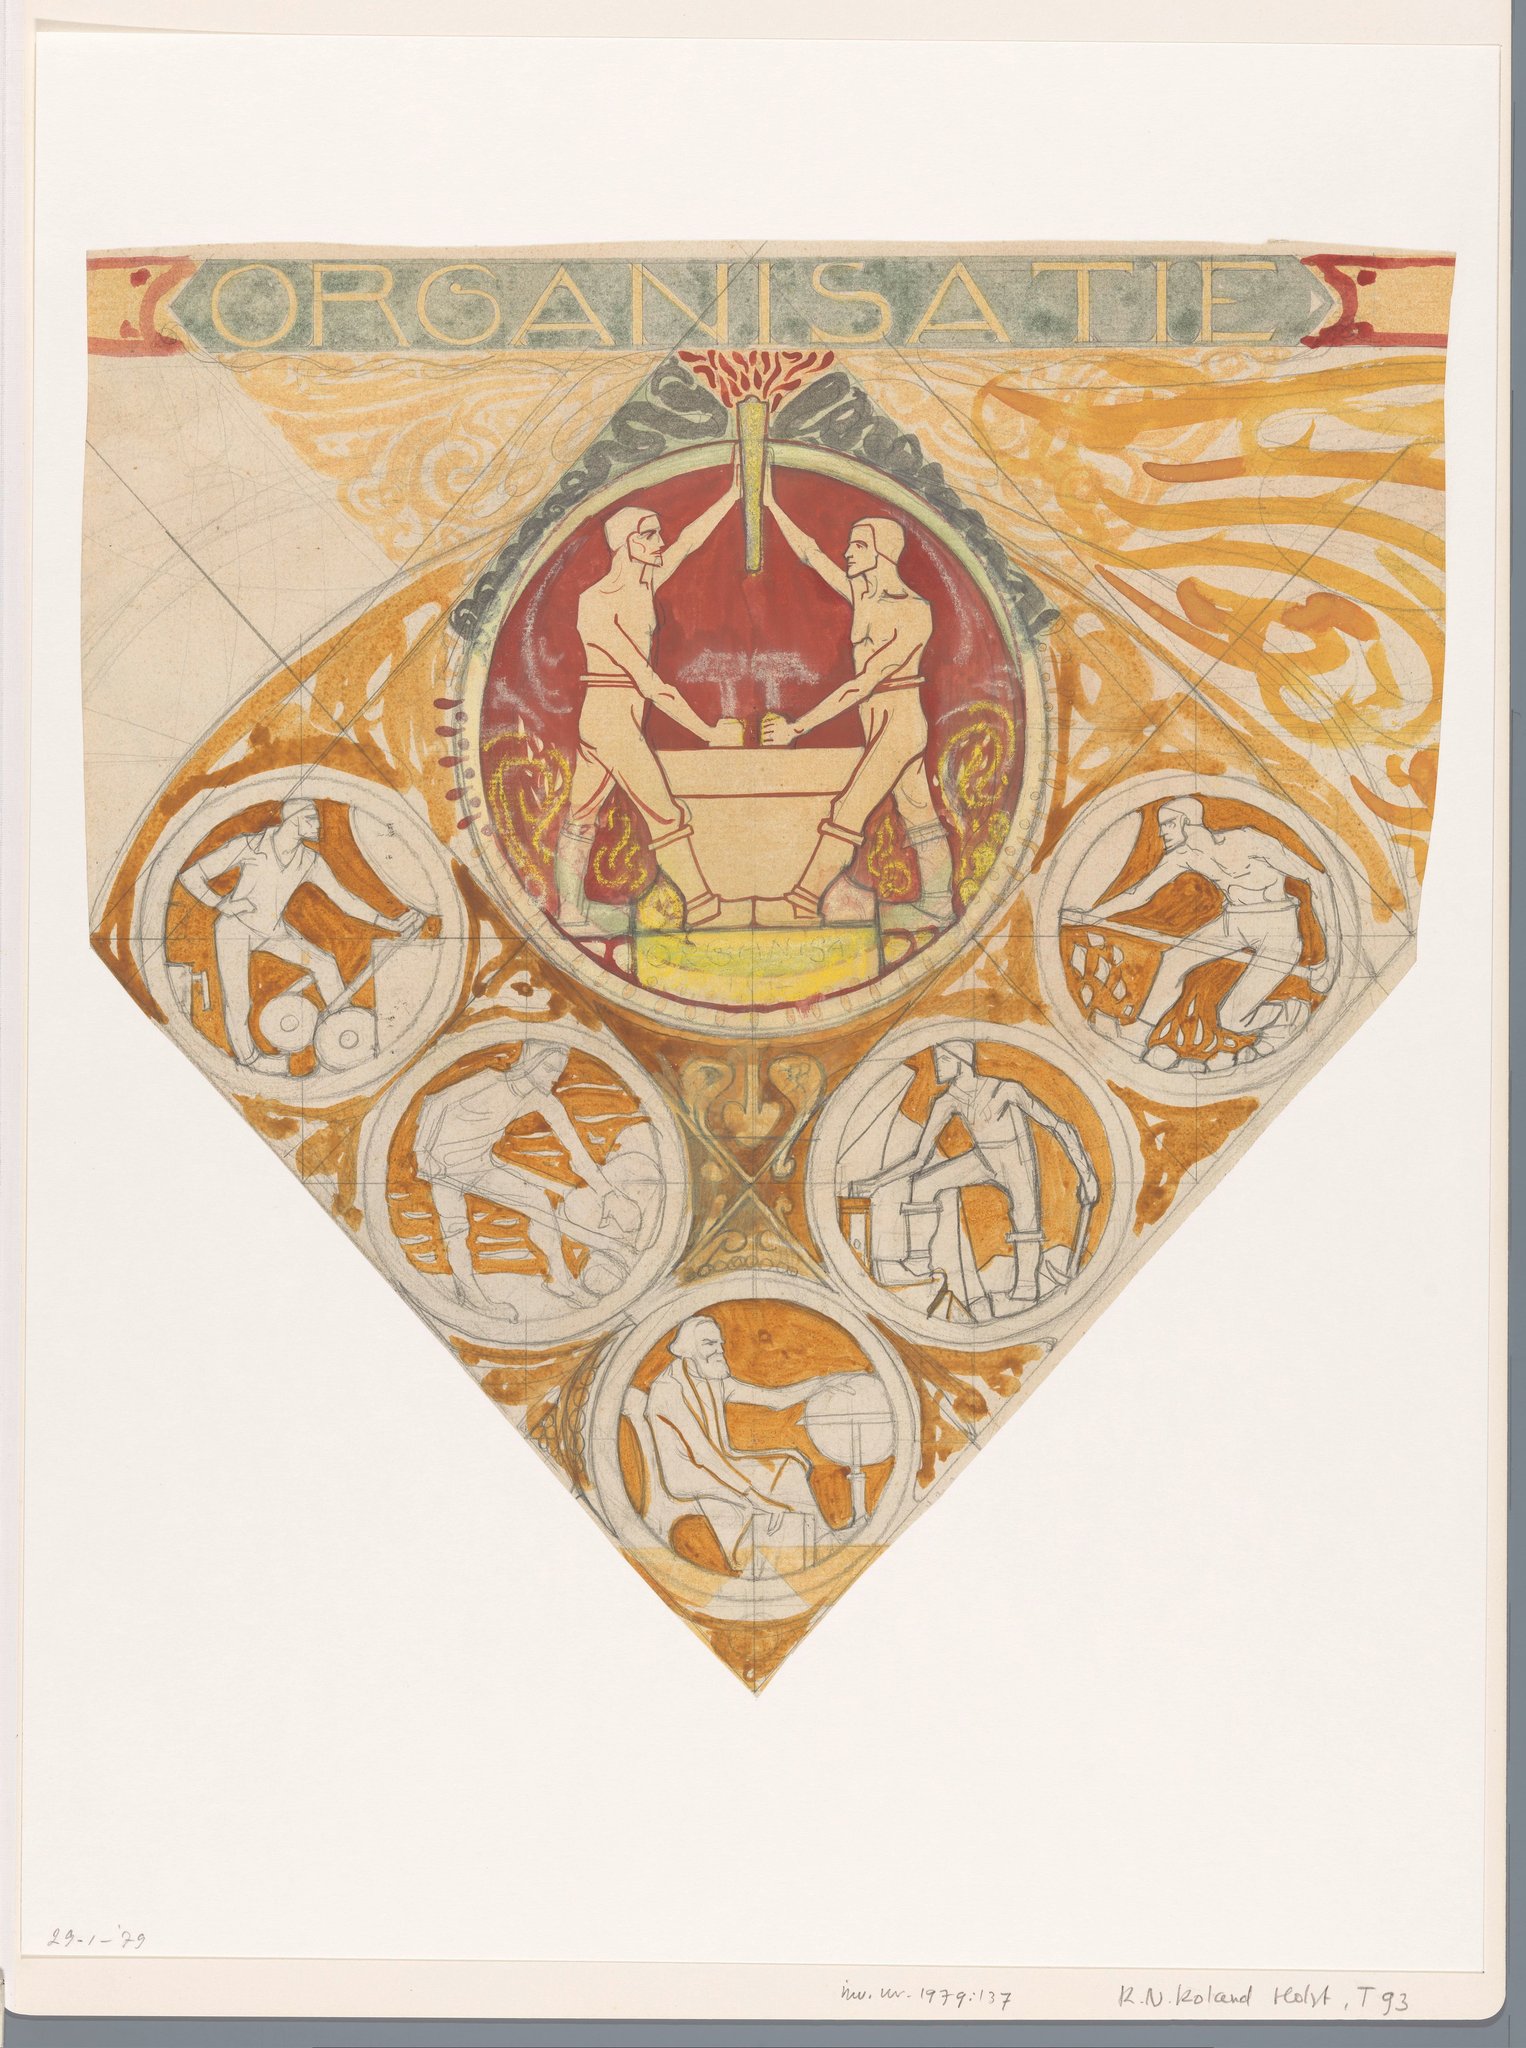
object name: design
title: Organisatie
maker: richard nicolaüs roland holst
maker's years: 1868-1938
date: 1878-1938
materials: chalk, paper, pencil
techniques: brush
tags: agreement, unity; 'concordia', 'concordia insuperabile', 'concordia militare', 'concordia di pace', 'unione civile' (ripa) (+ allegorical scene, i.e. two or more personifications involved in an action), order, arrangement, organization (+ allegorical scene, i.e. two or more personifications involved in an action), working class, labourers